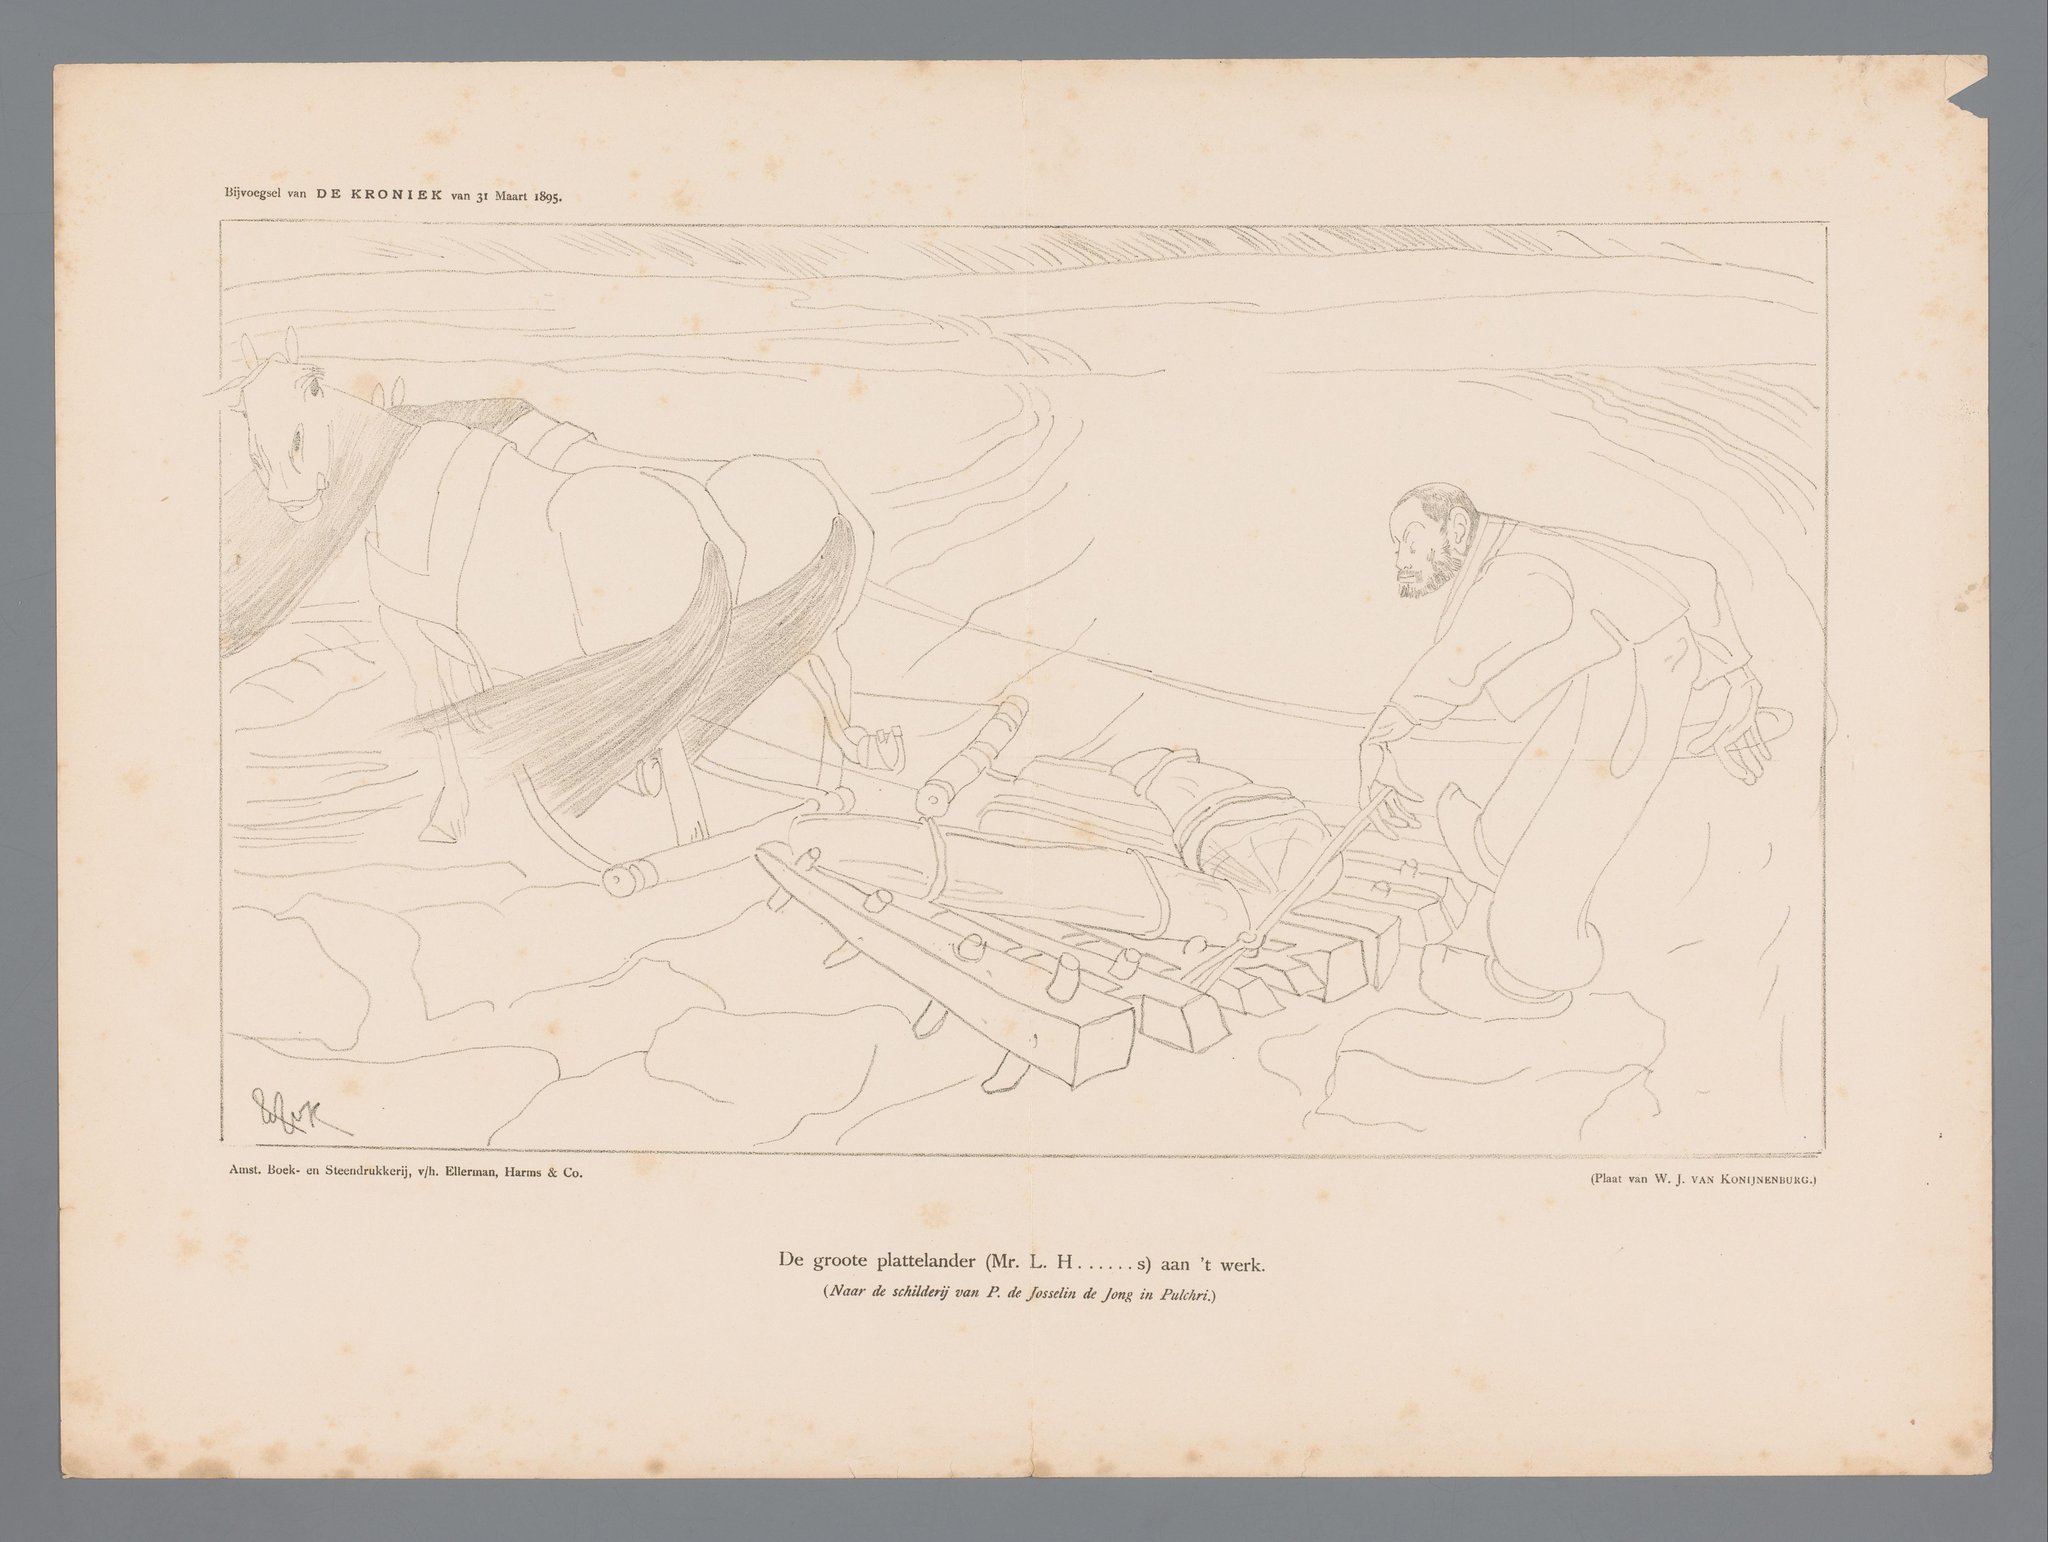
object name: cartoon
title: De groote plattelander (mr. L.H....s) aan 't werk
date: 1895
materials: paper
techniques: lithograph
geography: amsterdam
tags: china, politician, political caricatures and satires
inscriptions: date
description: Prent met titel en onderschrift, bijvoegsel bij 'De Kroniek'. Gesigneerd en gedateerd.